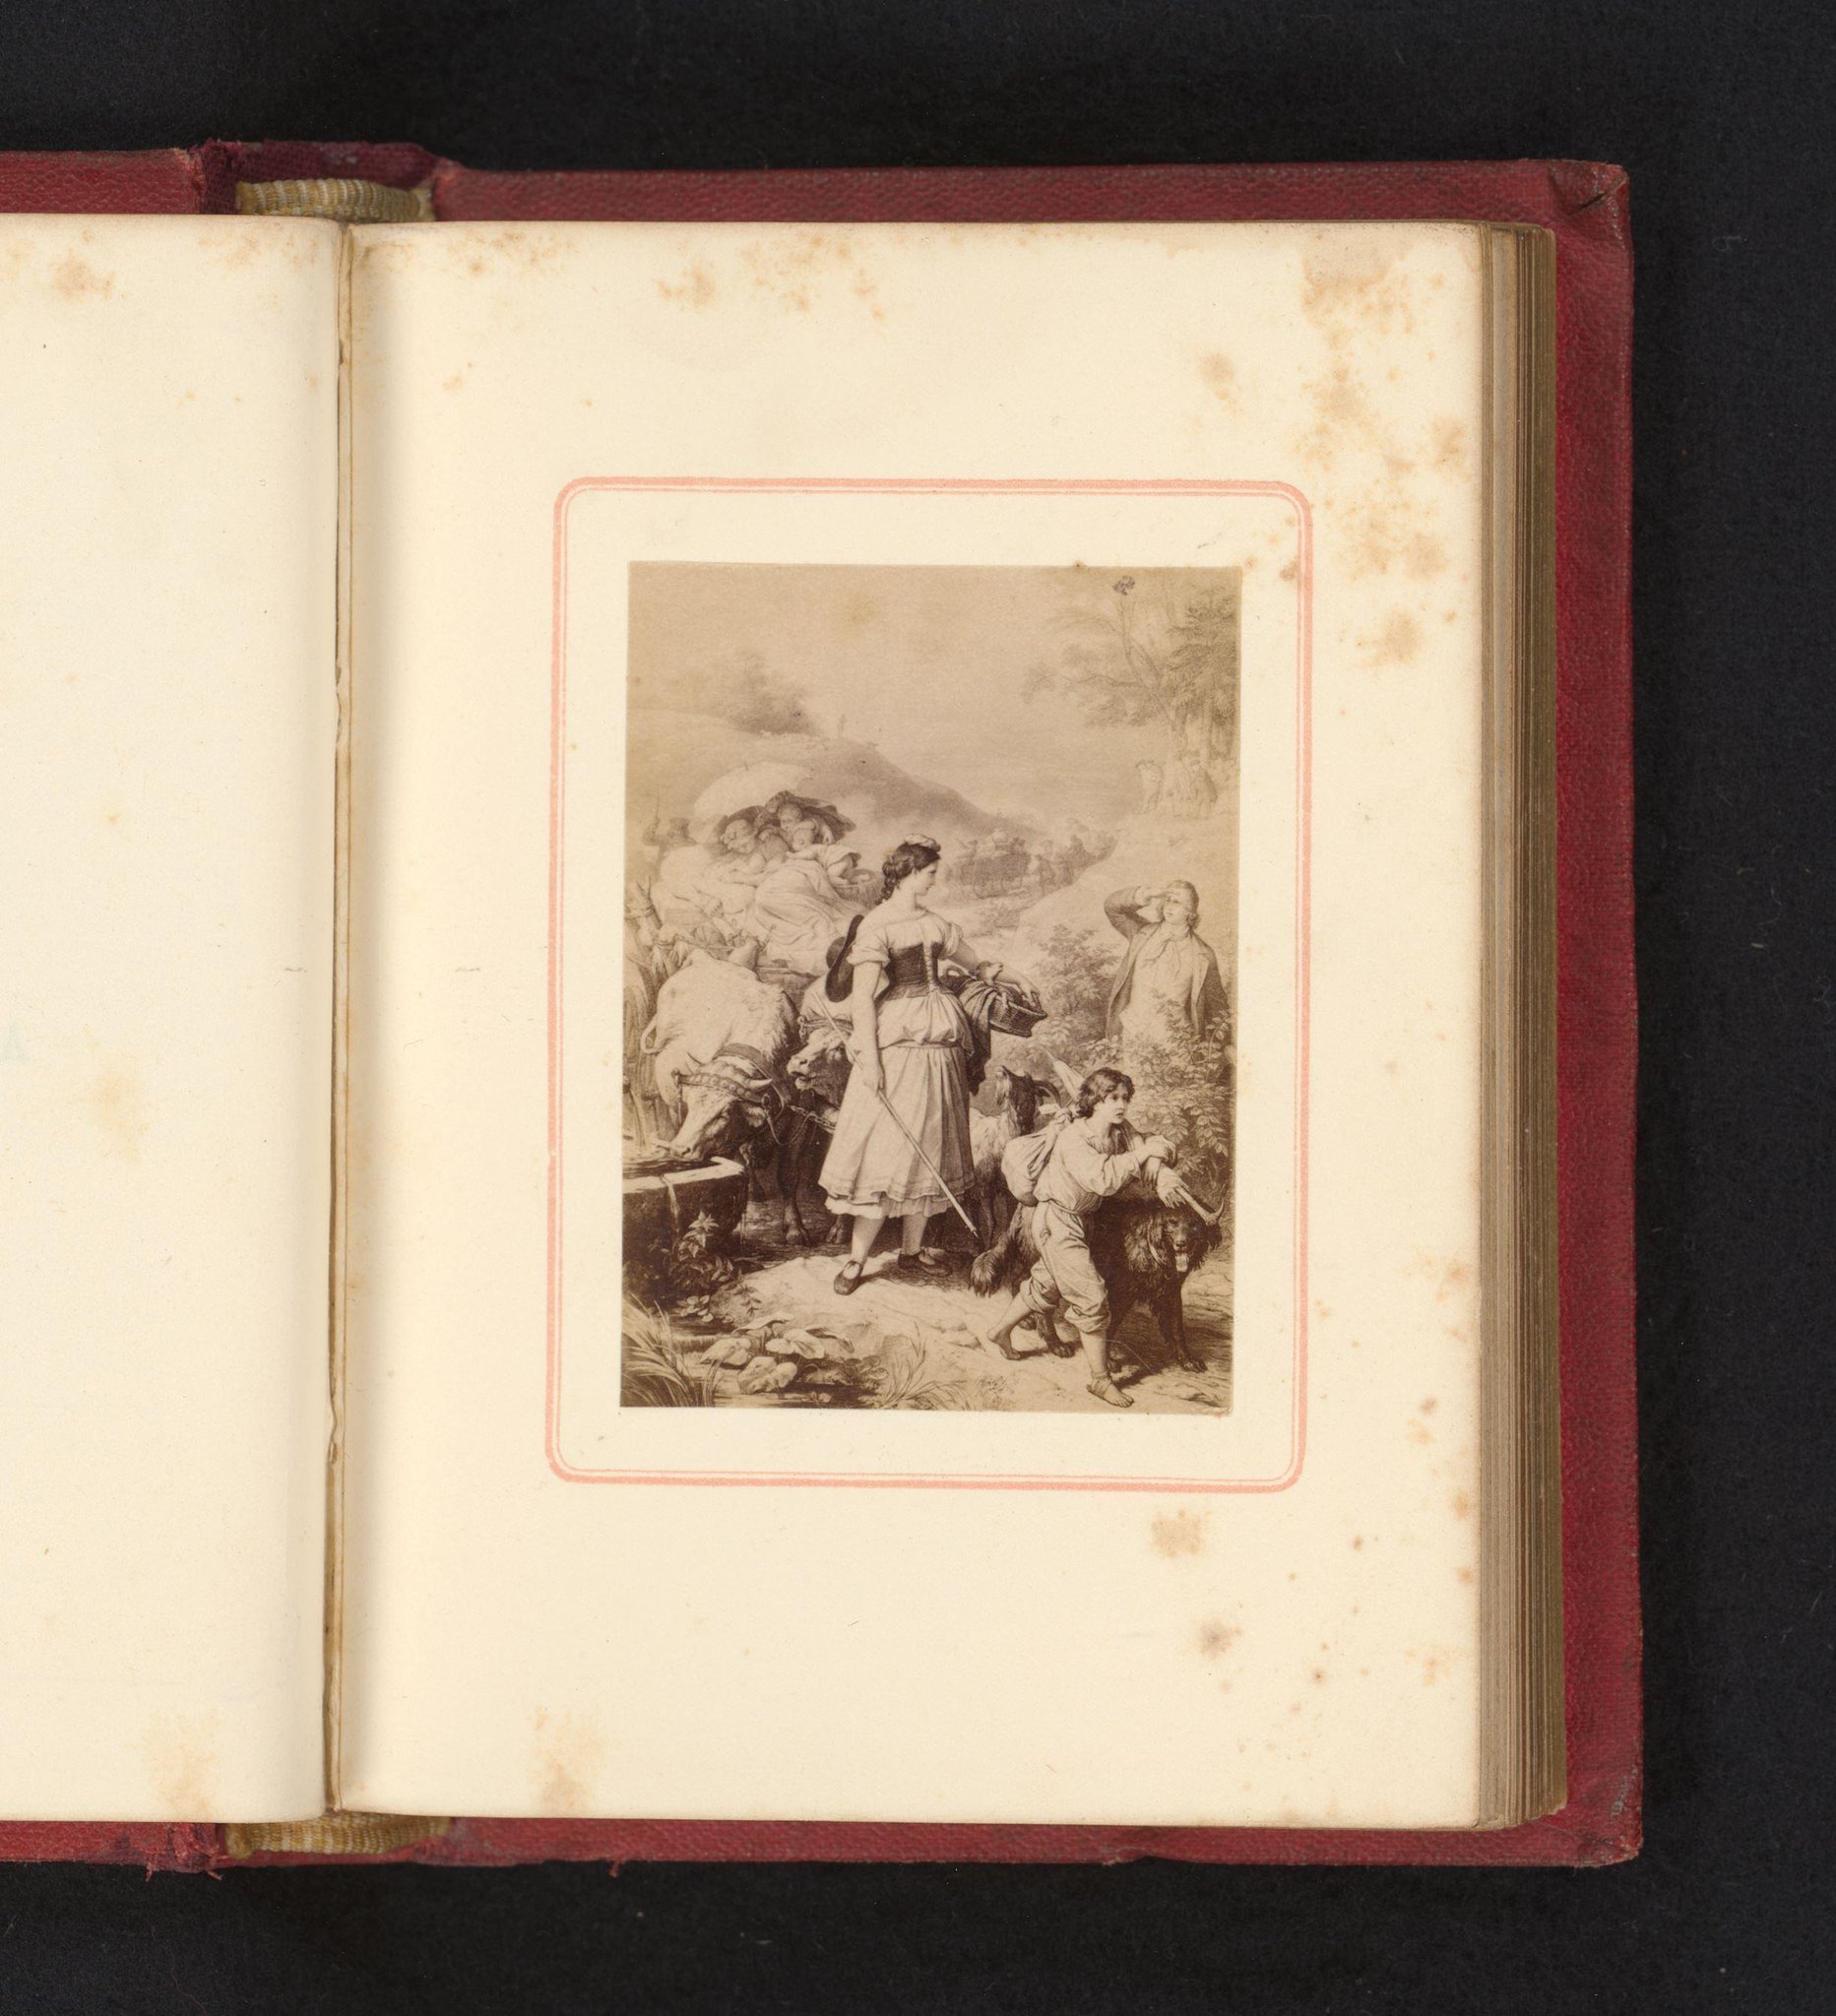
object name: page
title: Dorothea und die Auswanderer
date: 1860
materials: paper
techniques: albumen print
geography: munich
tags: drawing, sketch, female literary characters